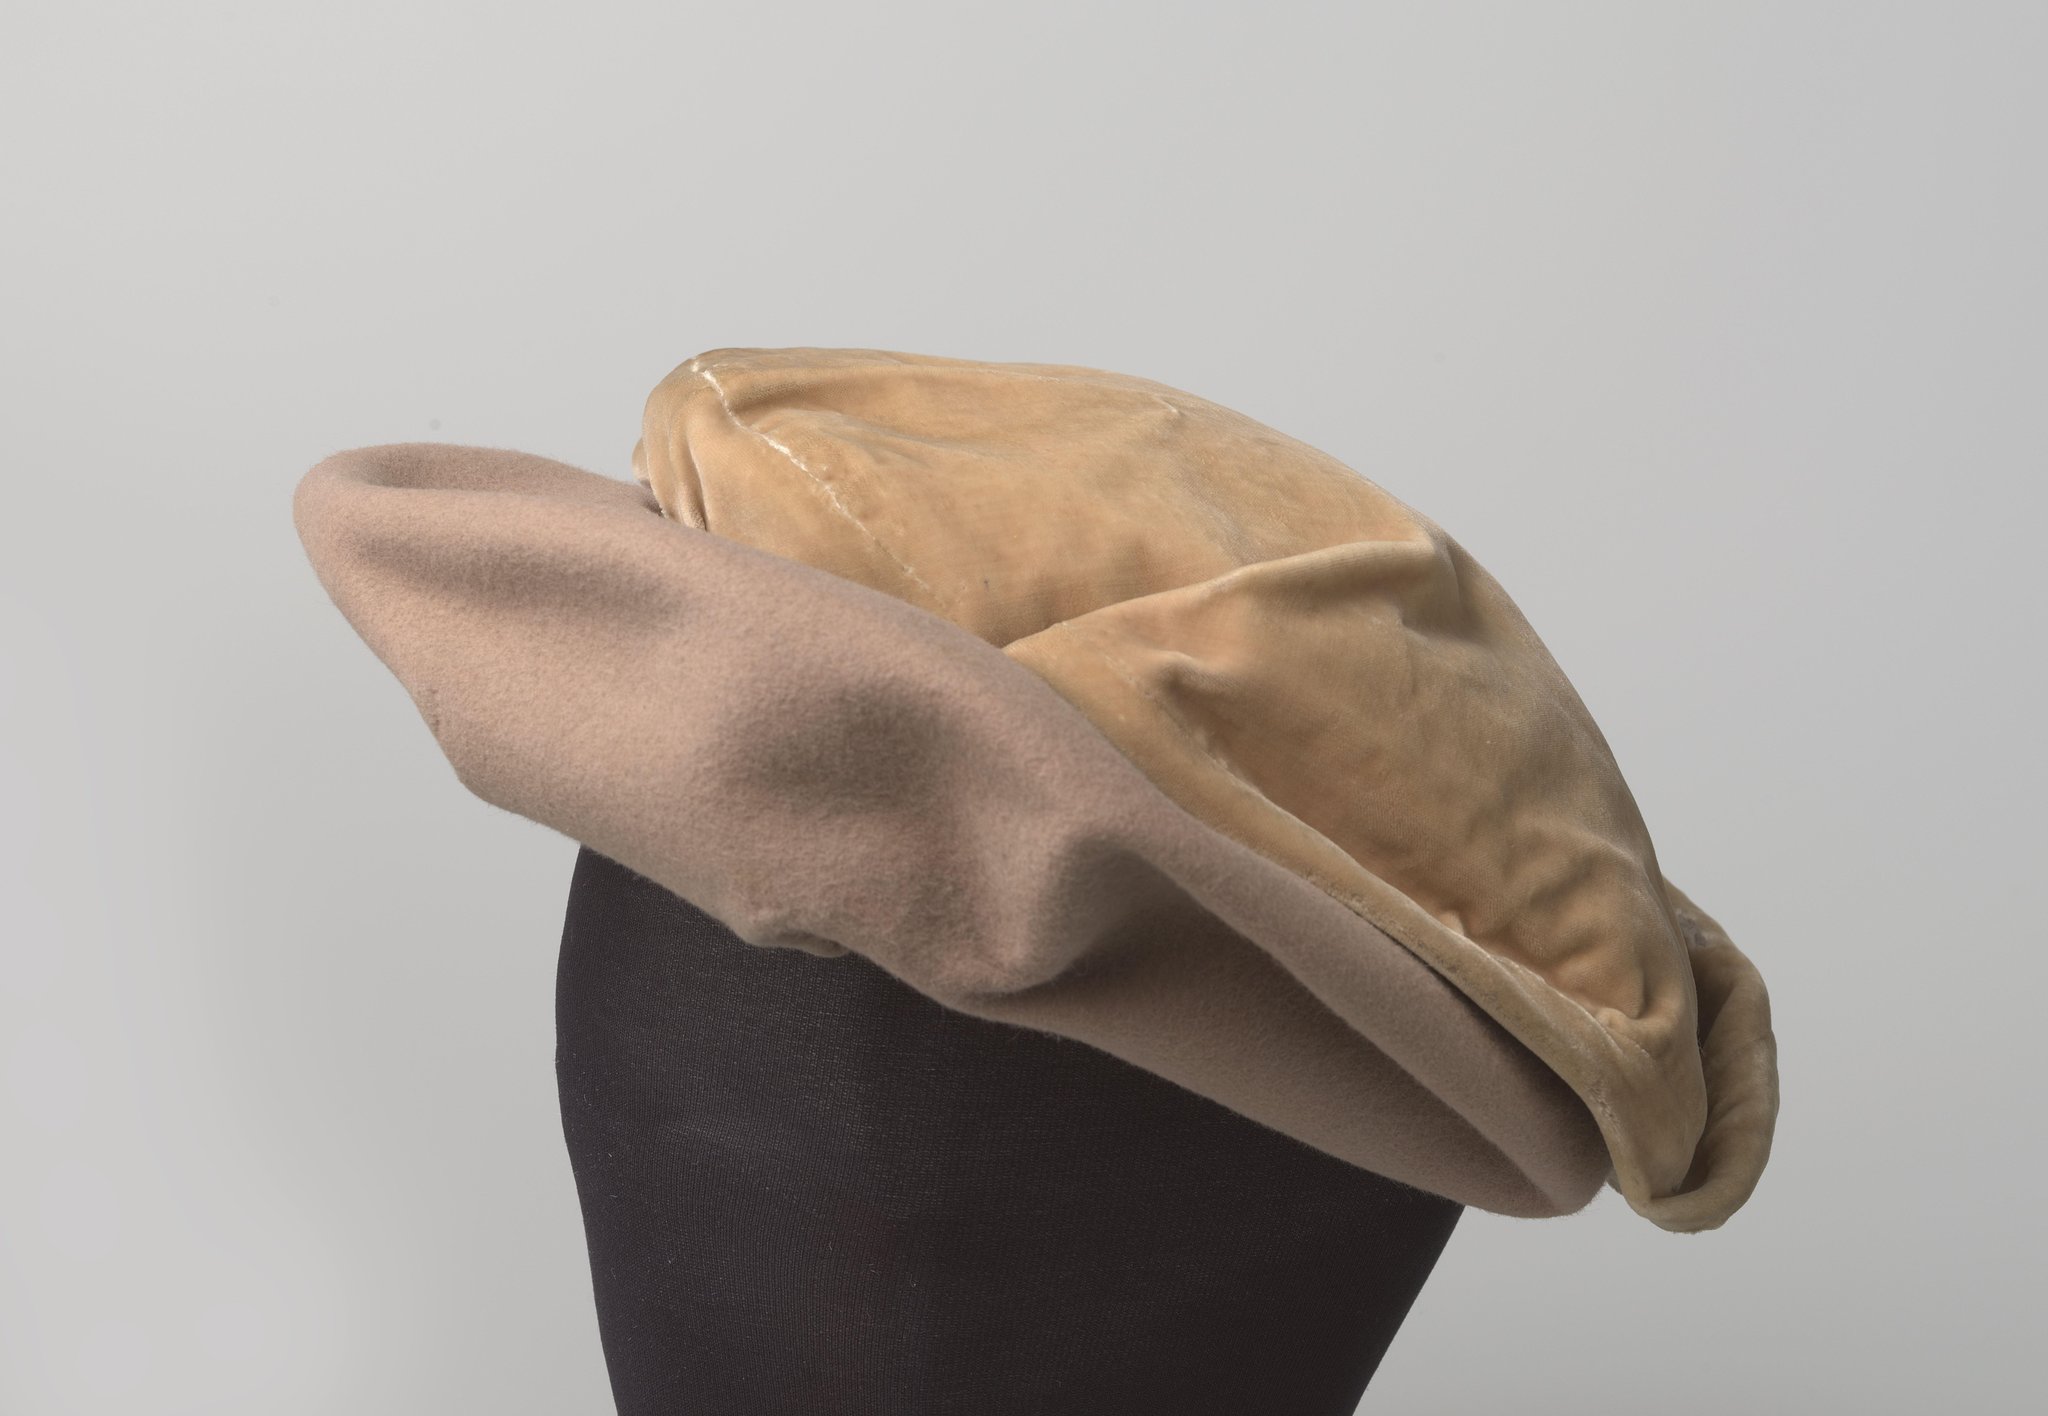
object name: beret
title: Baret met een bol van leverkleurig zijden fluweel en een rand in dezelfde kleur vilt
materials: silk, wool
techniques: pressing, weave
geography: paris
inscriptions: company name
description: Baret met een bol van leverkleurig zijden fluweel en een rand in dezelfde kleur vilt. Maud et Nano. Met de originele kartonnen doos (BK-1984-94-B).